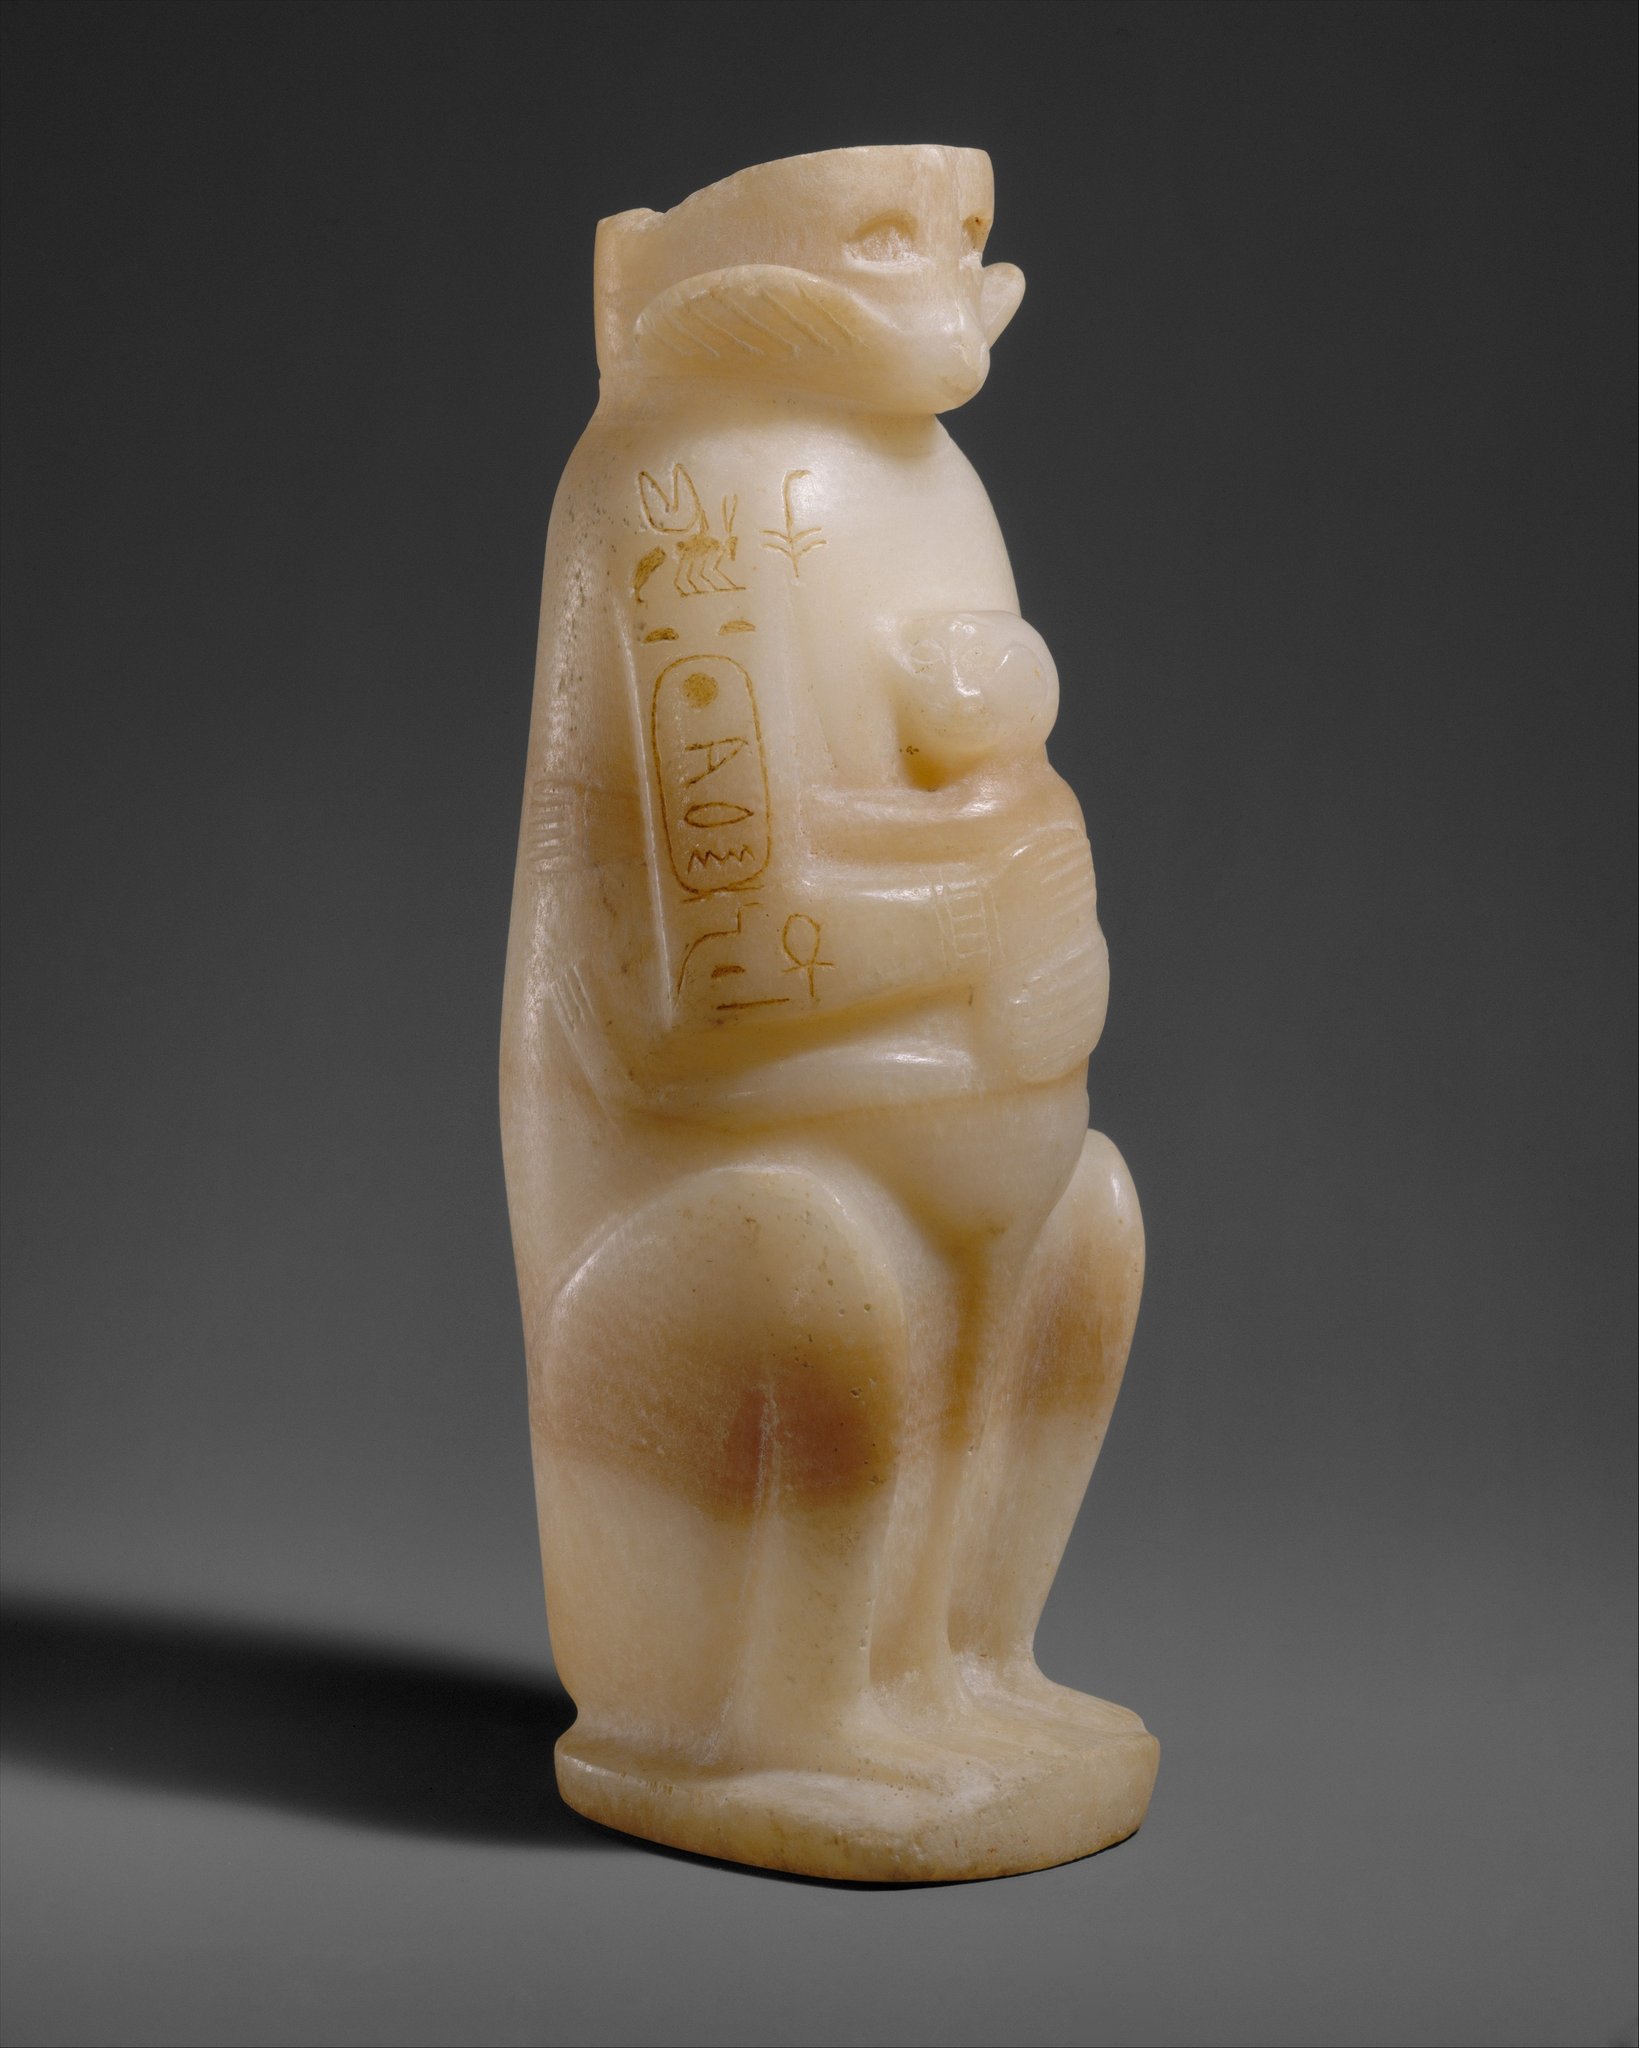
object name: vase, monkey, baby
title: Vase in the Shape of Mother Monkey with Her Young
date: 2255-2246 BCE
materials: paint, pigment, stone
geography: egypt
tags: monkeys